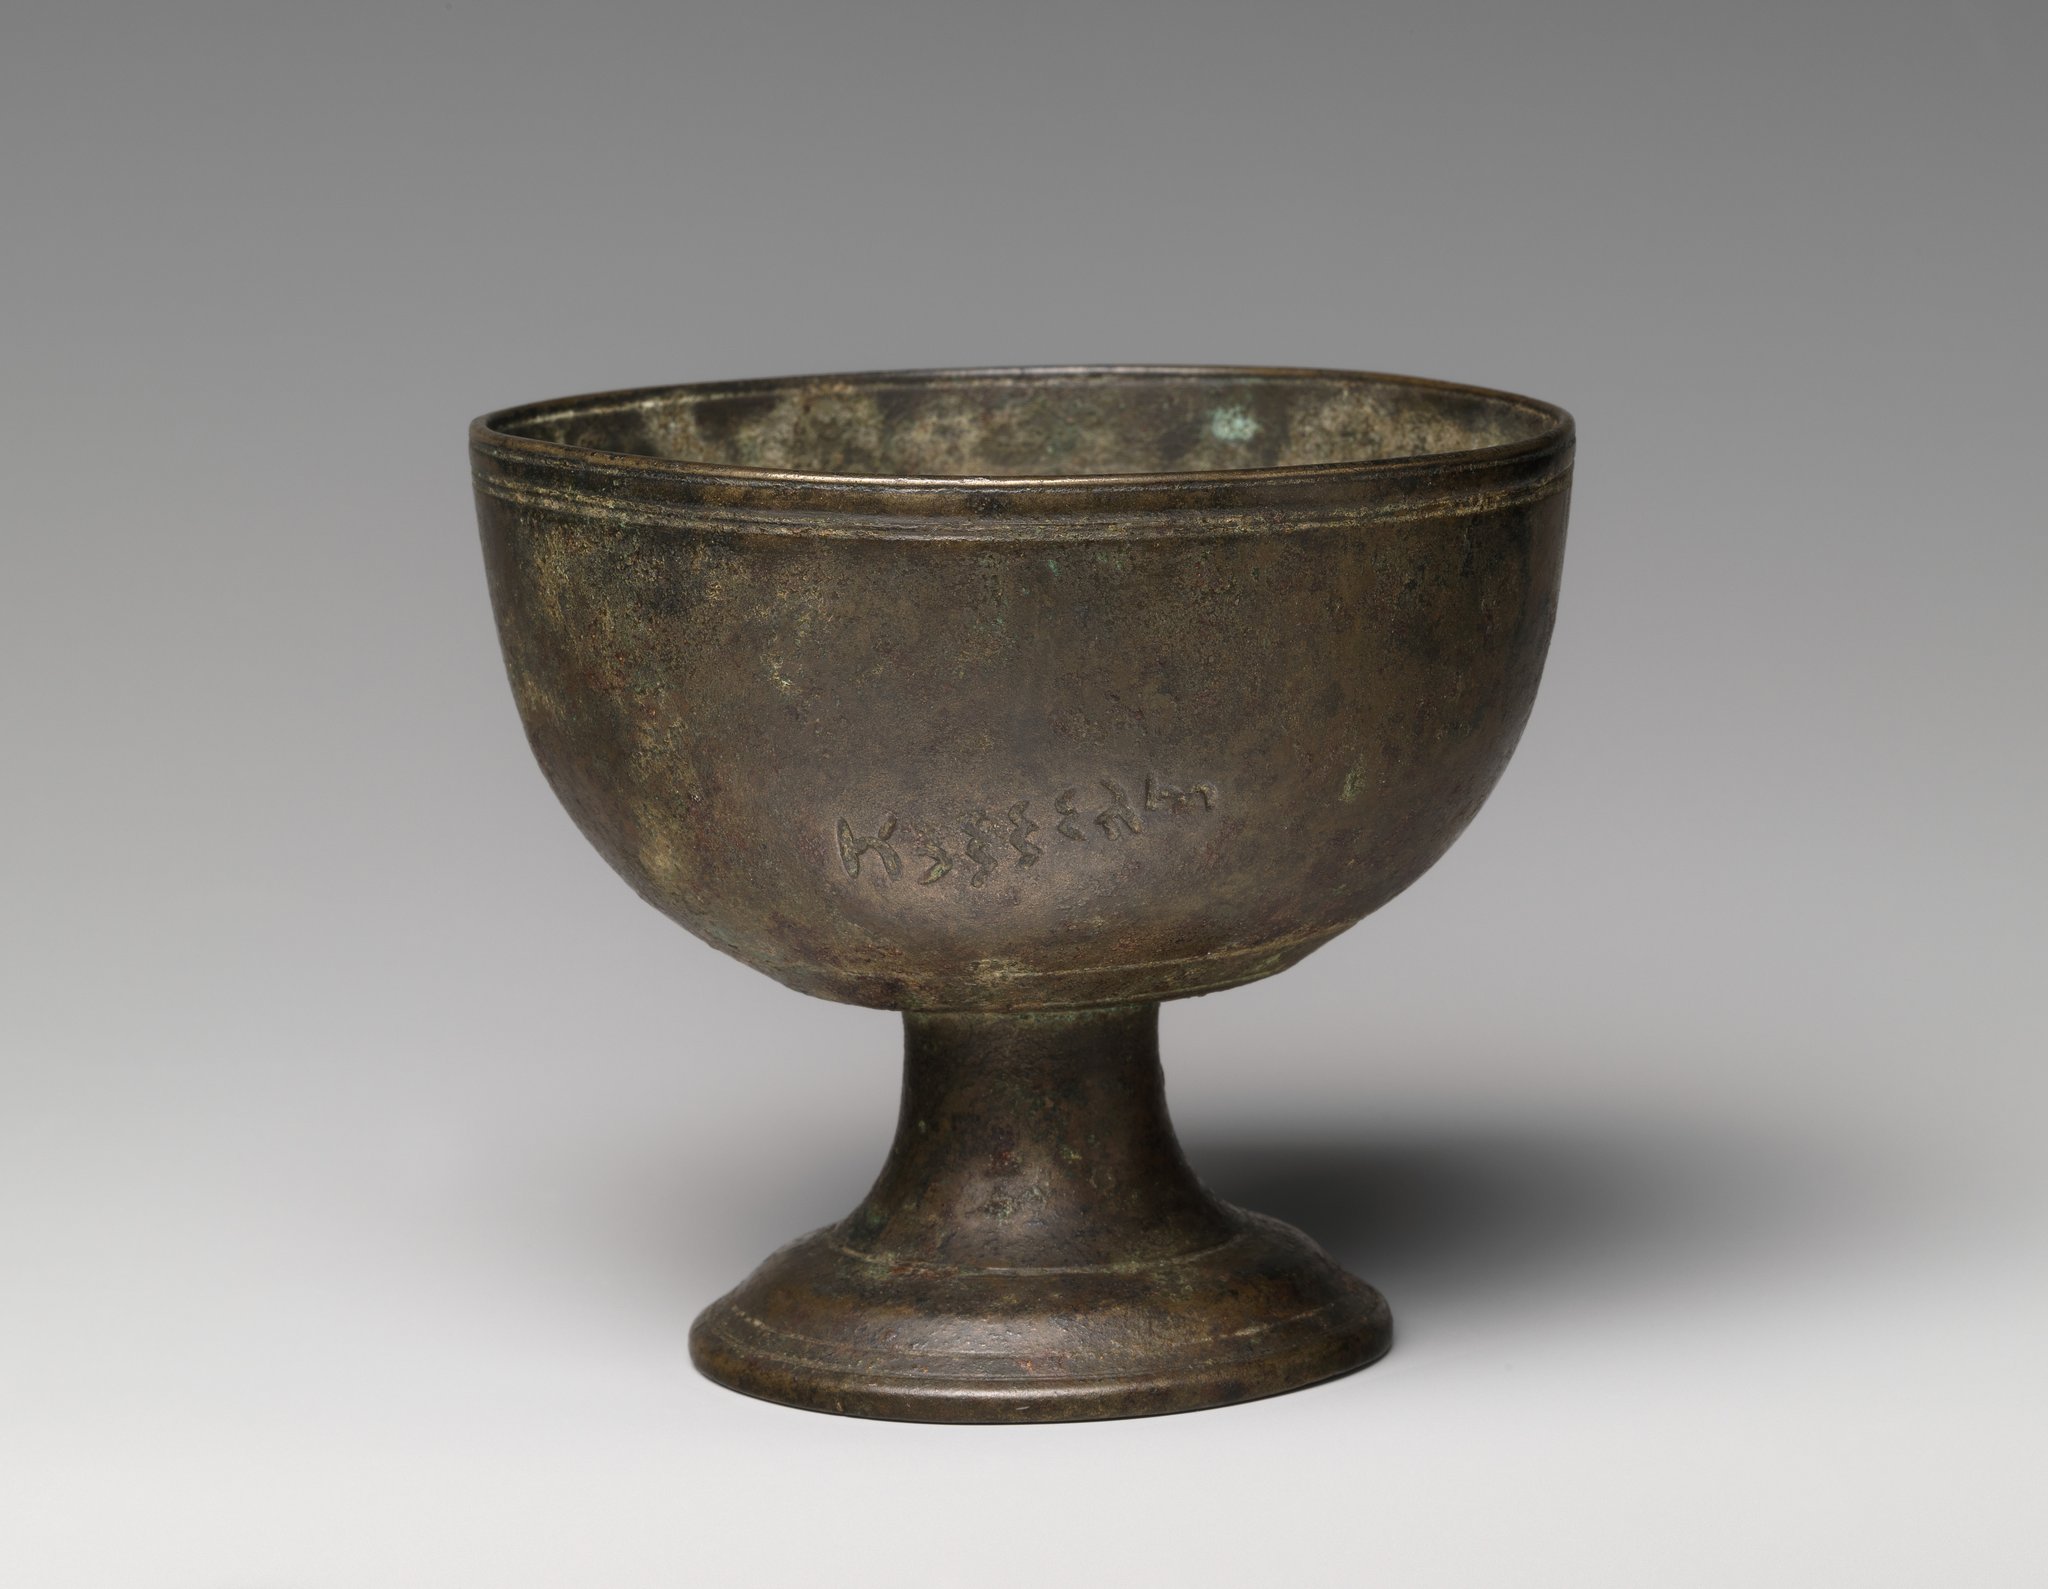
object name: chalice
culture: indian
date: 101-400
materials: bronze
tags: gandhara